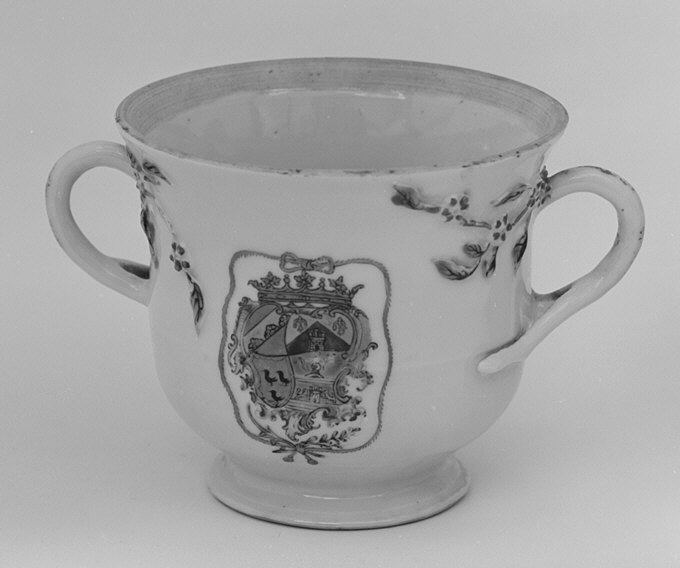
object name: sugar bowl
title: Sugar bowl (part of a service)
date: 1760-1770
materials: hard paste porcelain